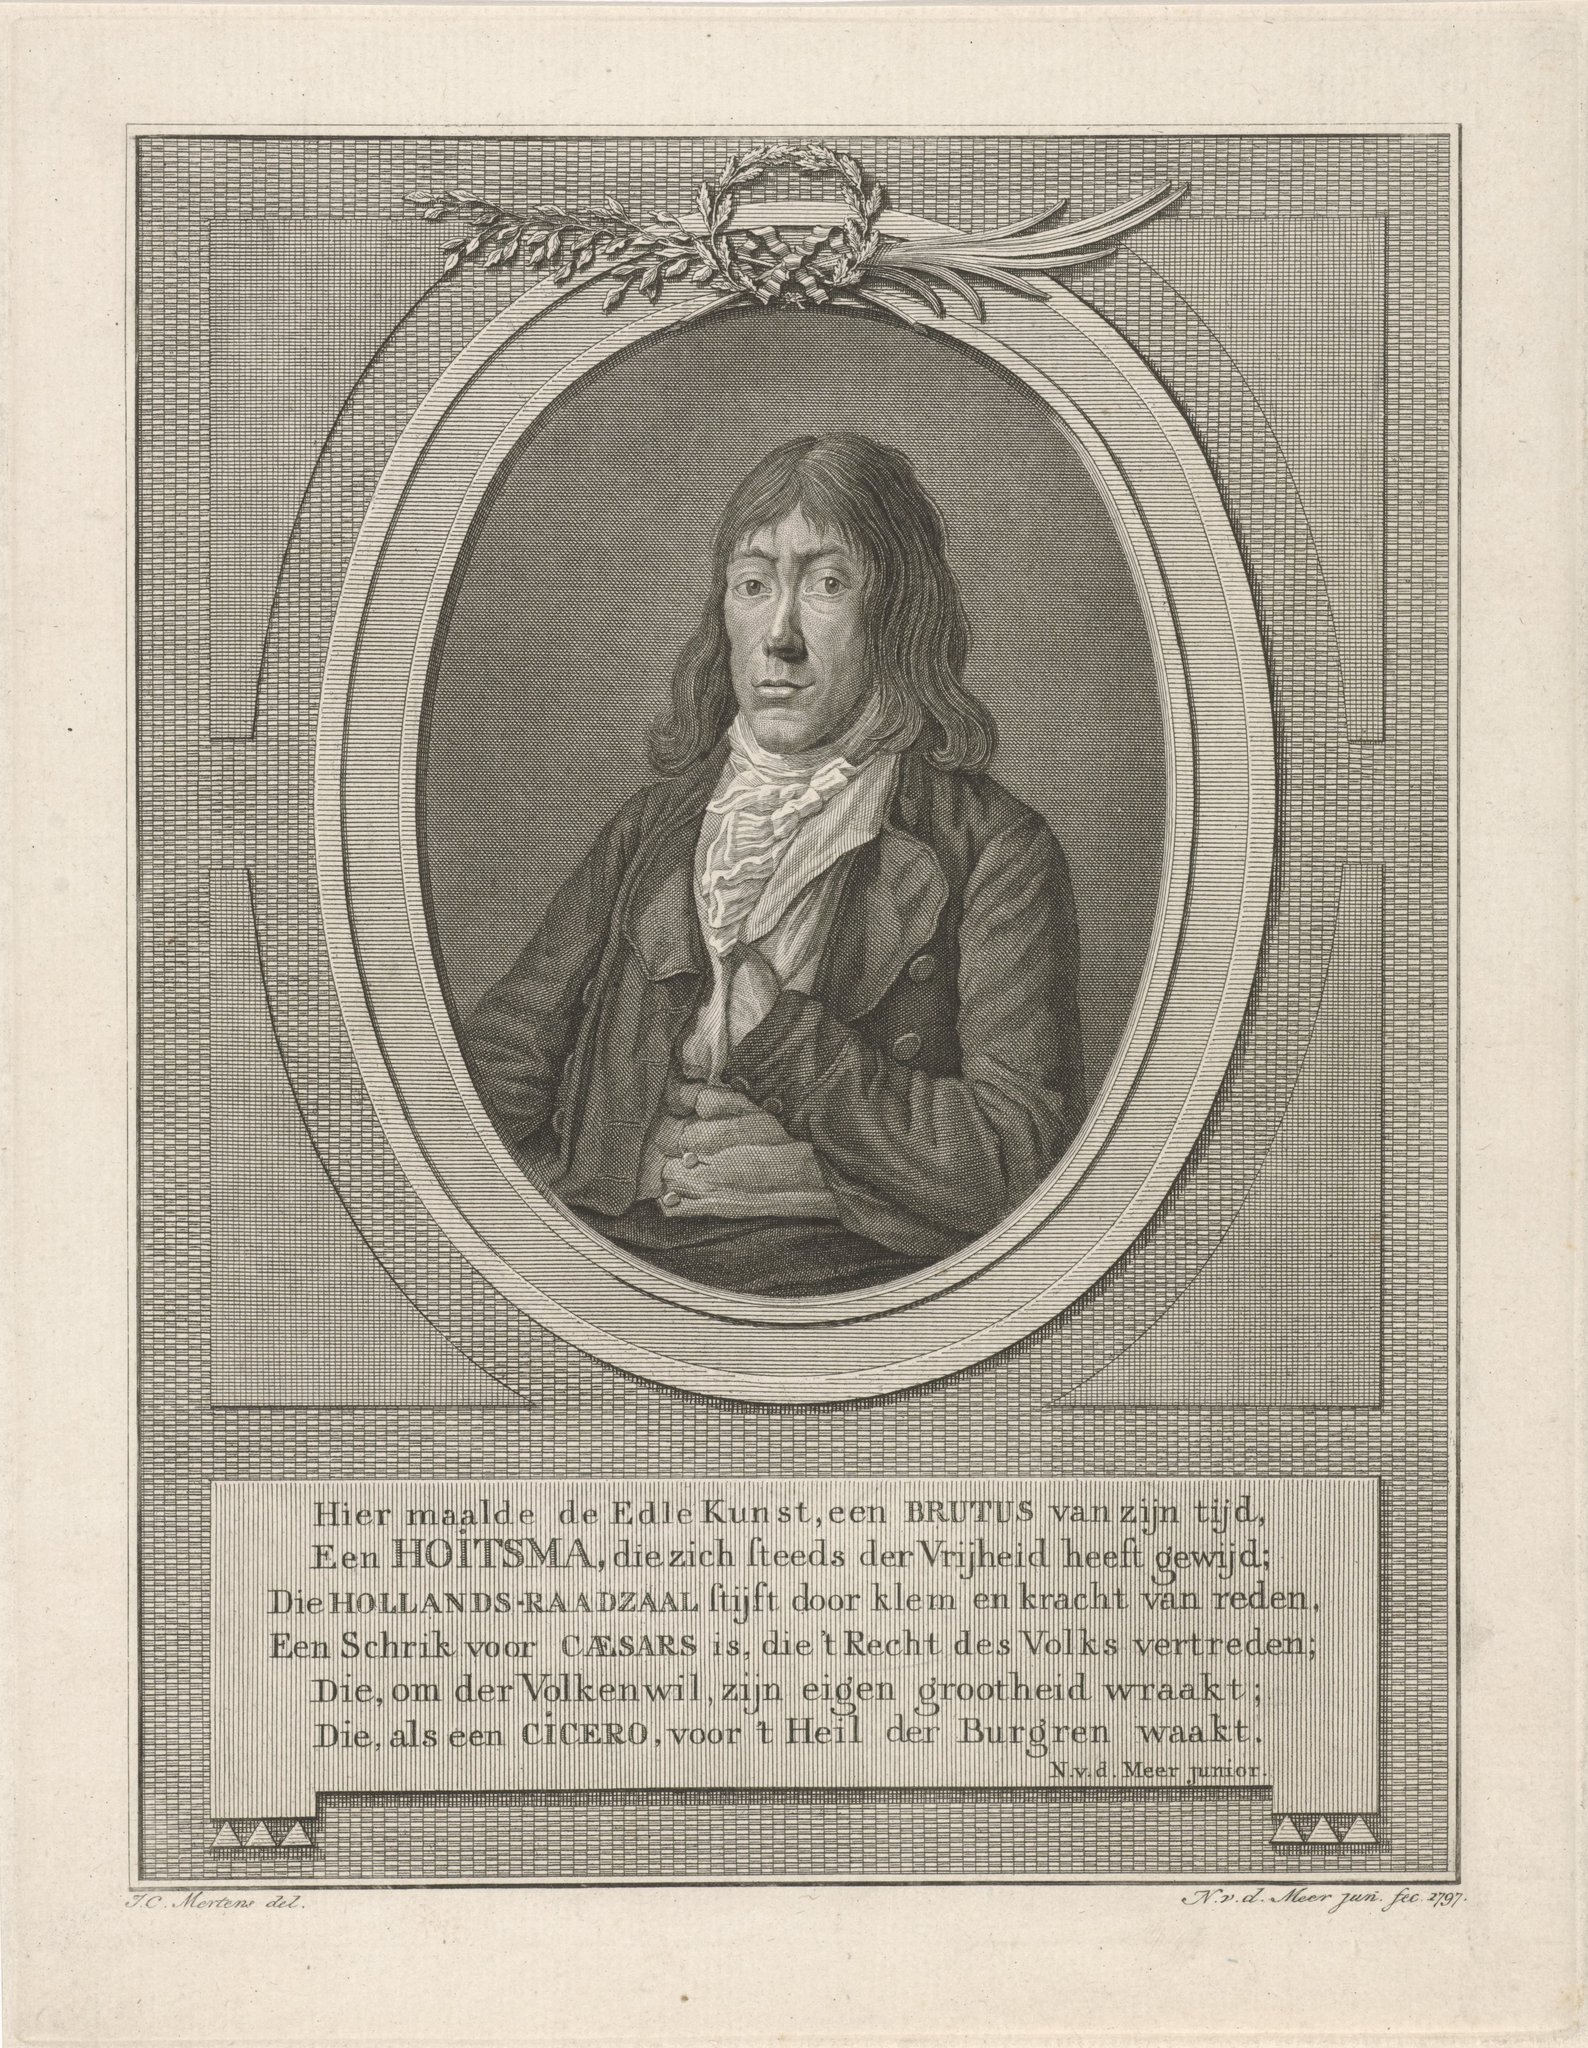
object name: print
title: Portret van Dirk Hoitsma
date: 1797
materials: paper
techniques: etching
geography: amsterdam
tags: accra, dirk hoitsma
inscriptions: collector's mark: Lugt 2228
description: Portret van Dirk Hoitsma, lid van het provinciaal bestuur van Holland. Onderaan een zesregelig vers.